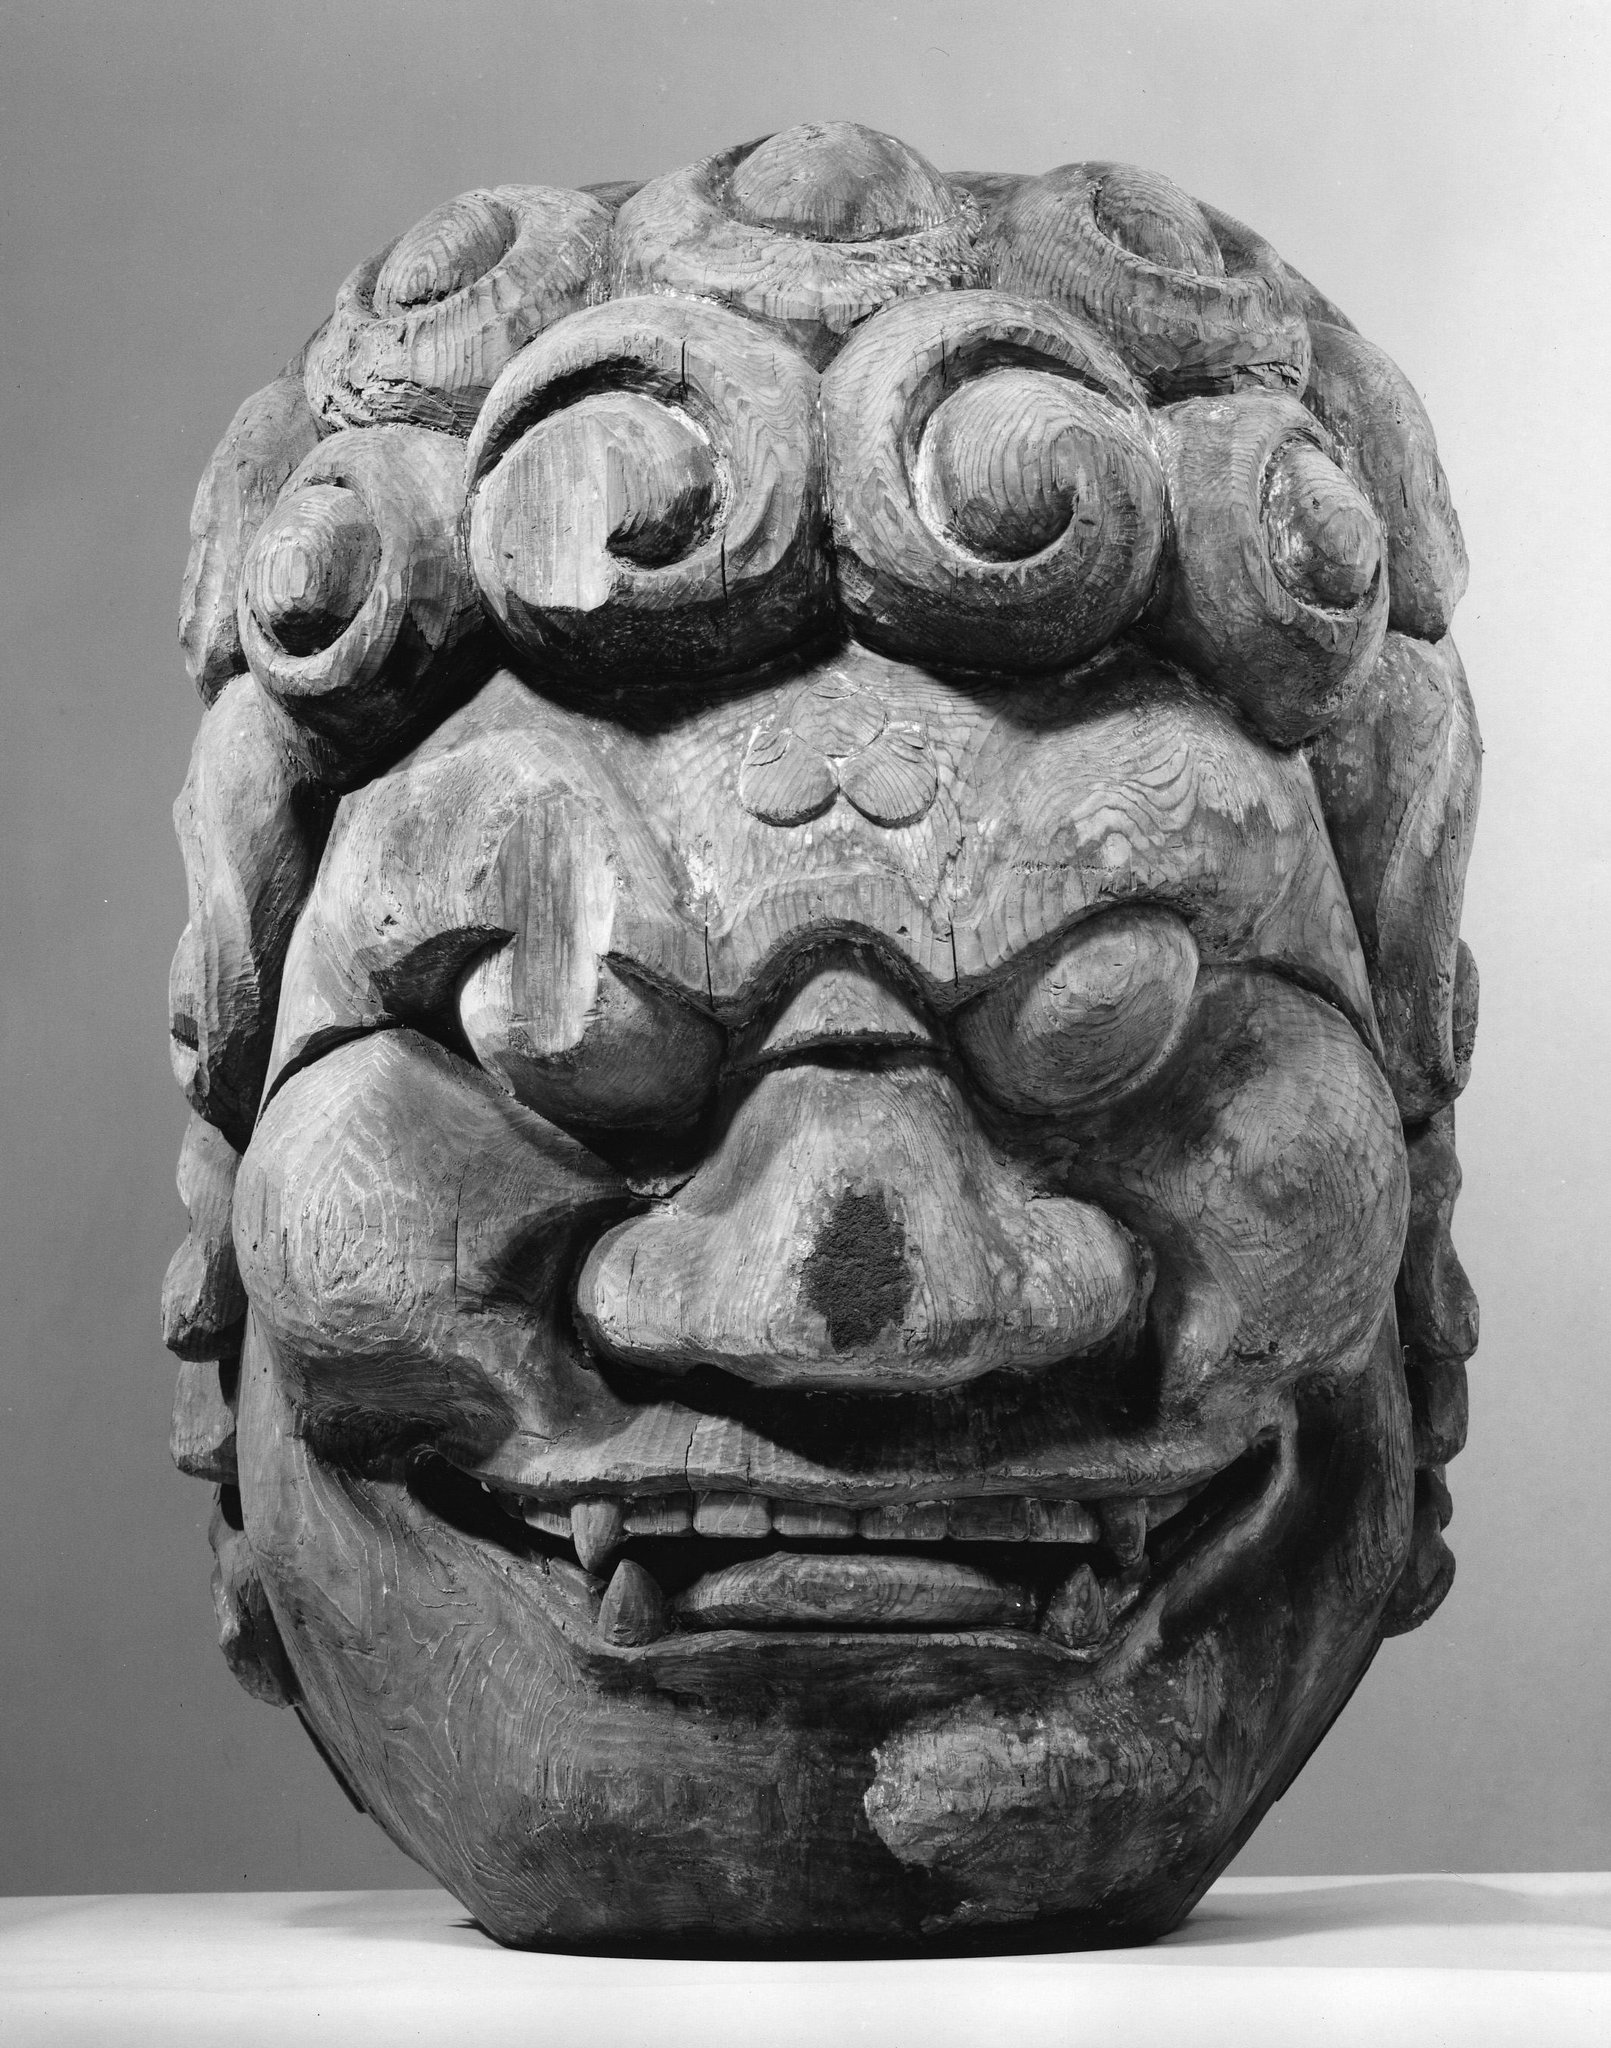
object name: head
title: Head from Colossal Statue of Guardian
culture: japanese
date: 1601-1800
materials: iron, wood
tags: heads